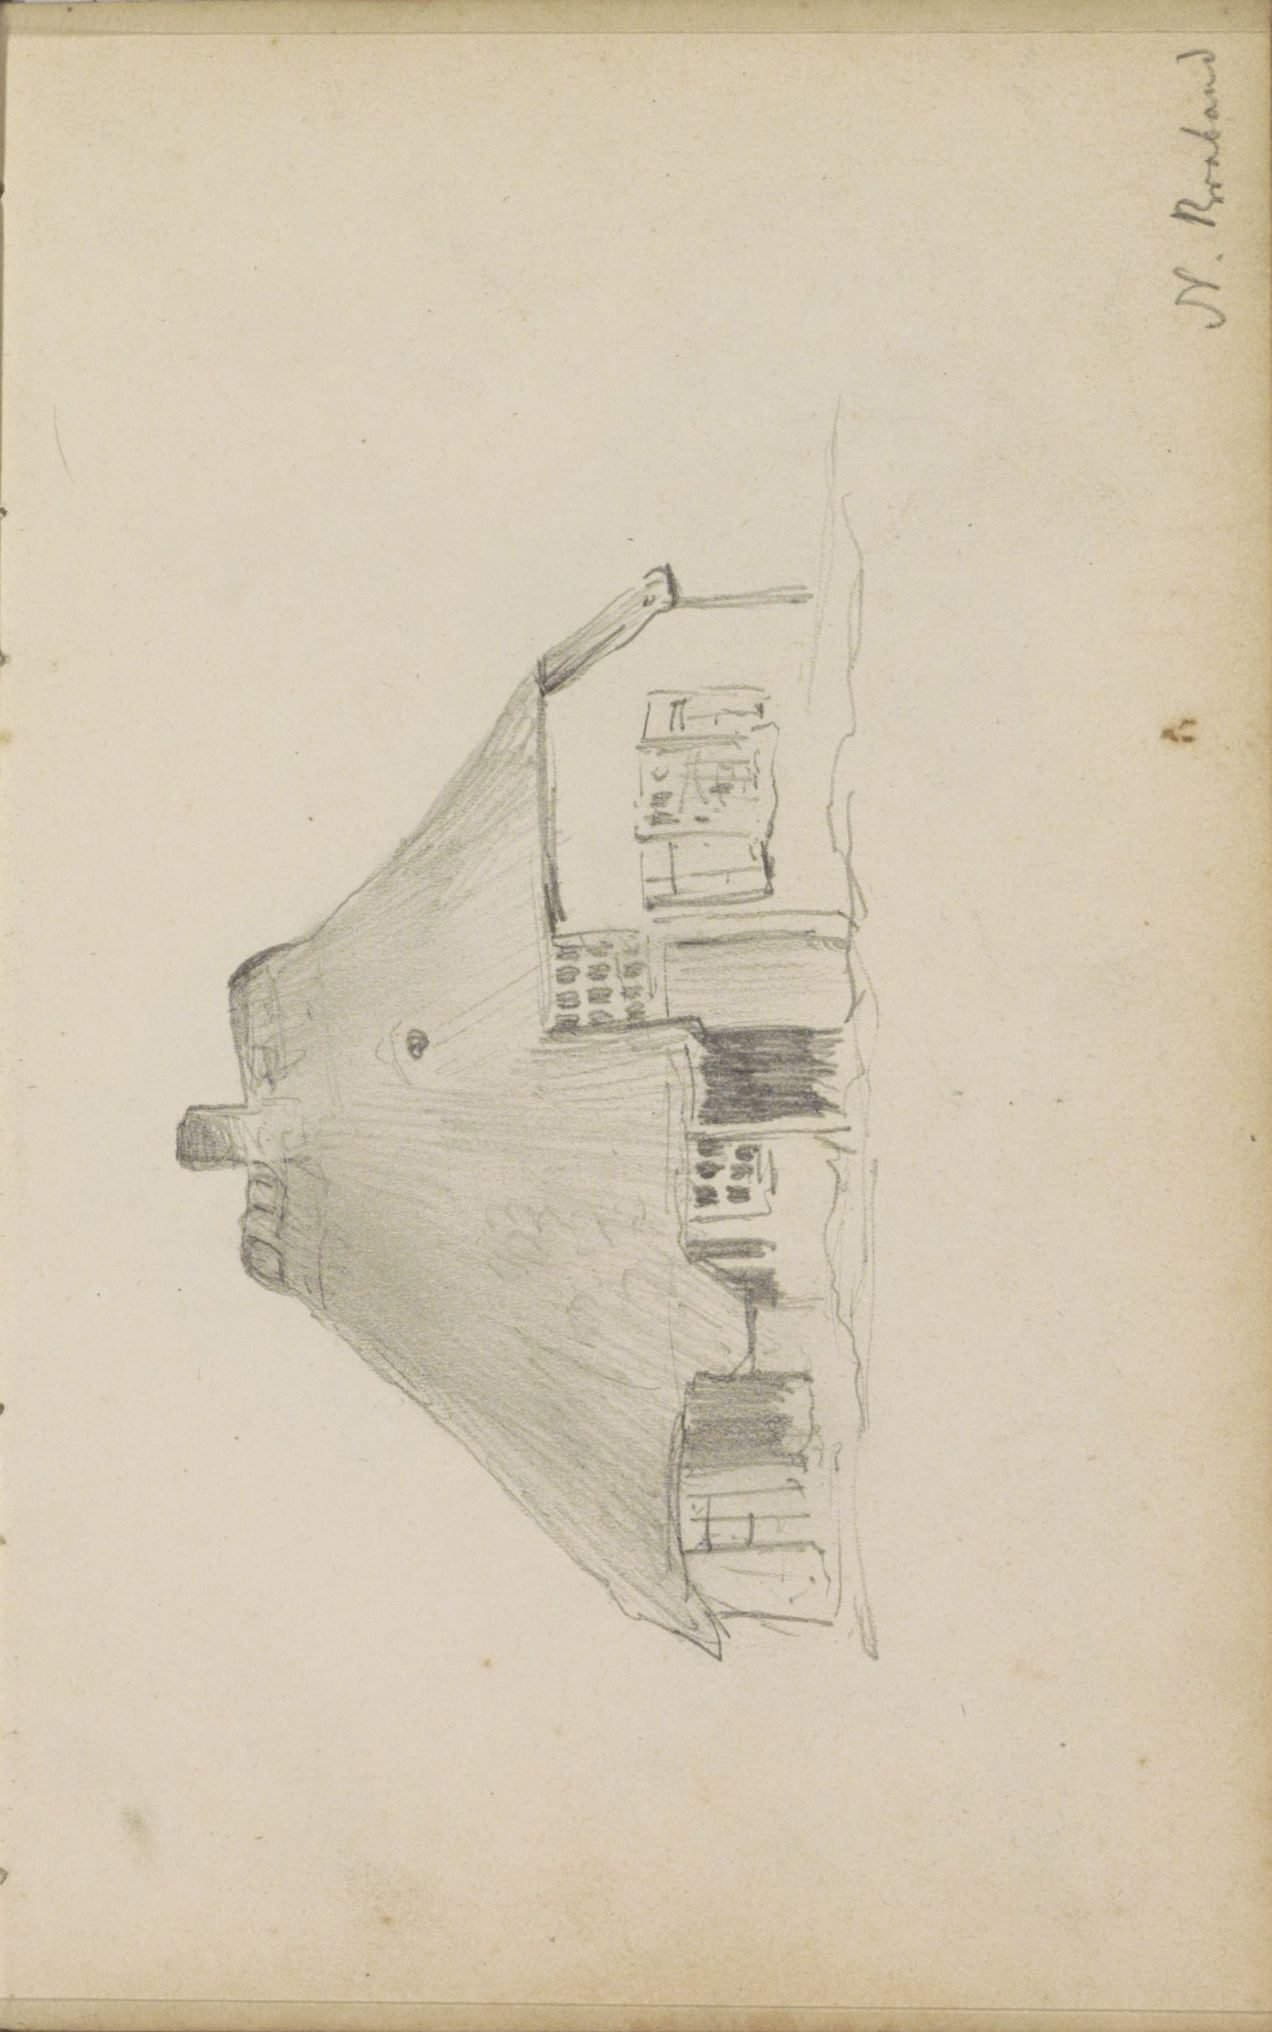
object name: sketchbook leaf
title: Hut met rieten kap in Noord-Brabant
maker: johannes tavenraat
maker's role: draughtsman, painter, print maker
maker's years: 1809-1881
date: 1839-1872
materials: paper, pencil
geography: north brabant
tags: farm (building)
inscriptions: annotation: ‘N. Braband’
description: Blad 34 recto uit een schetsboek met 73 bladen.